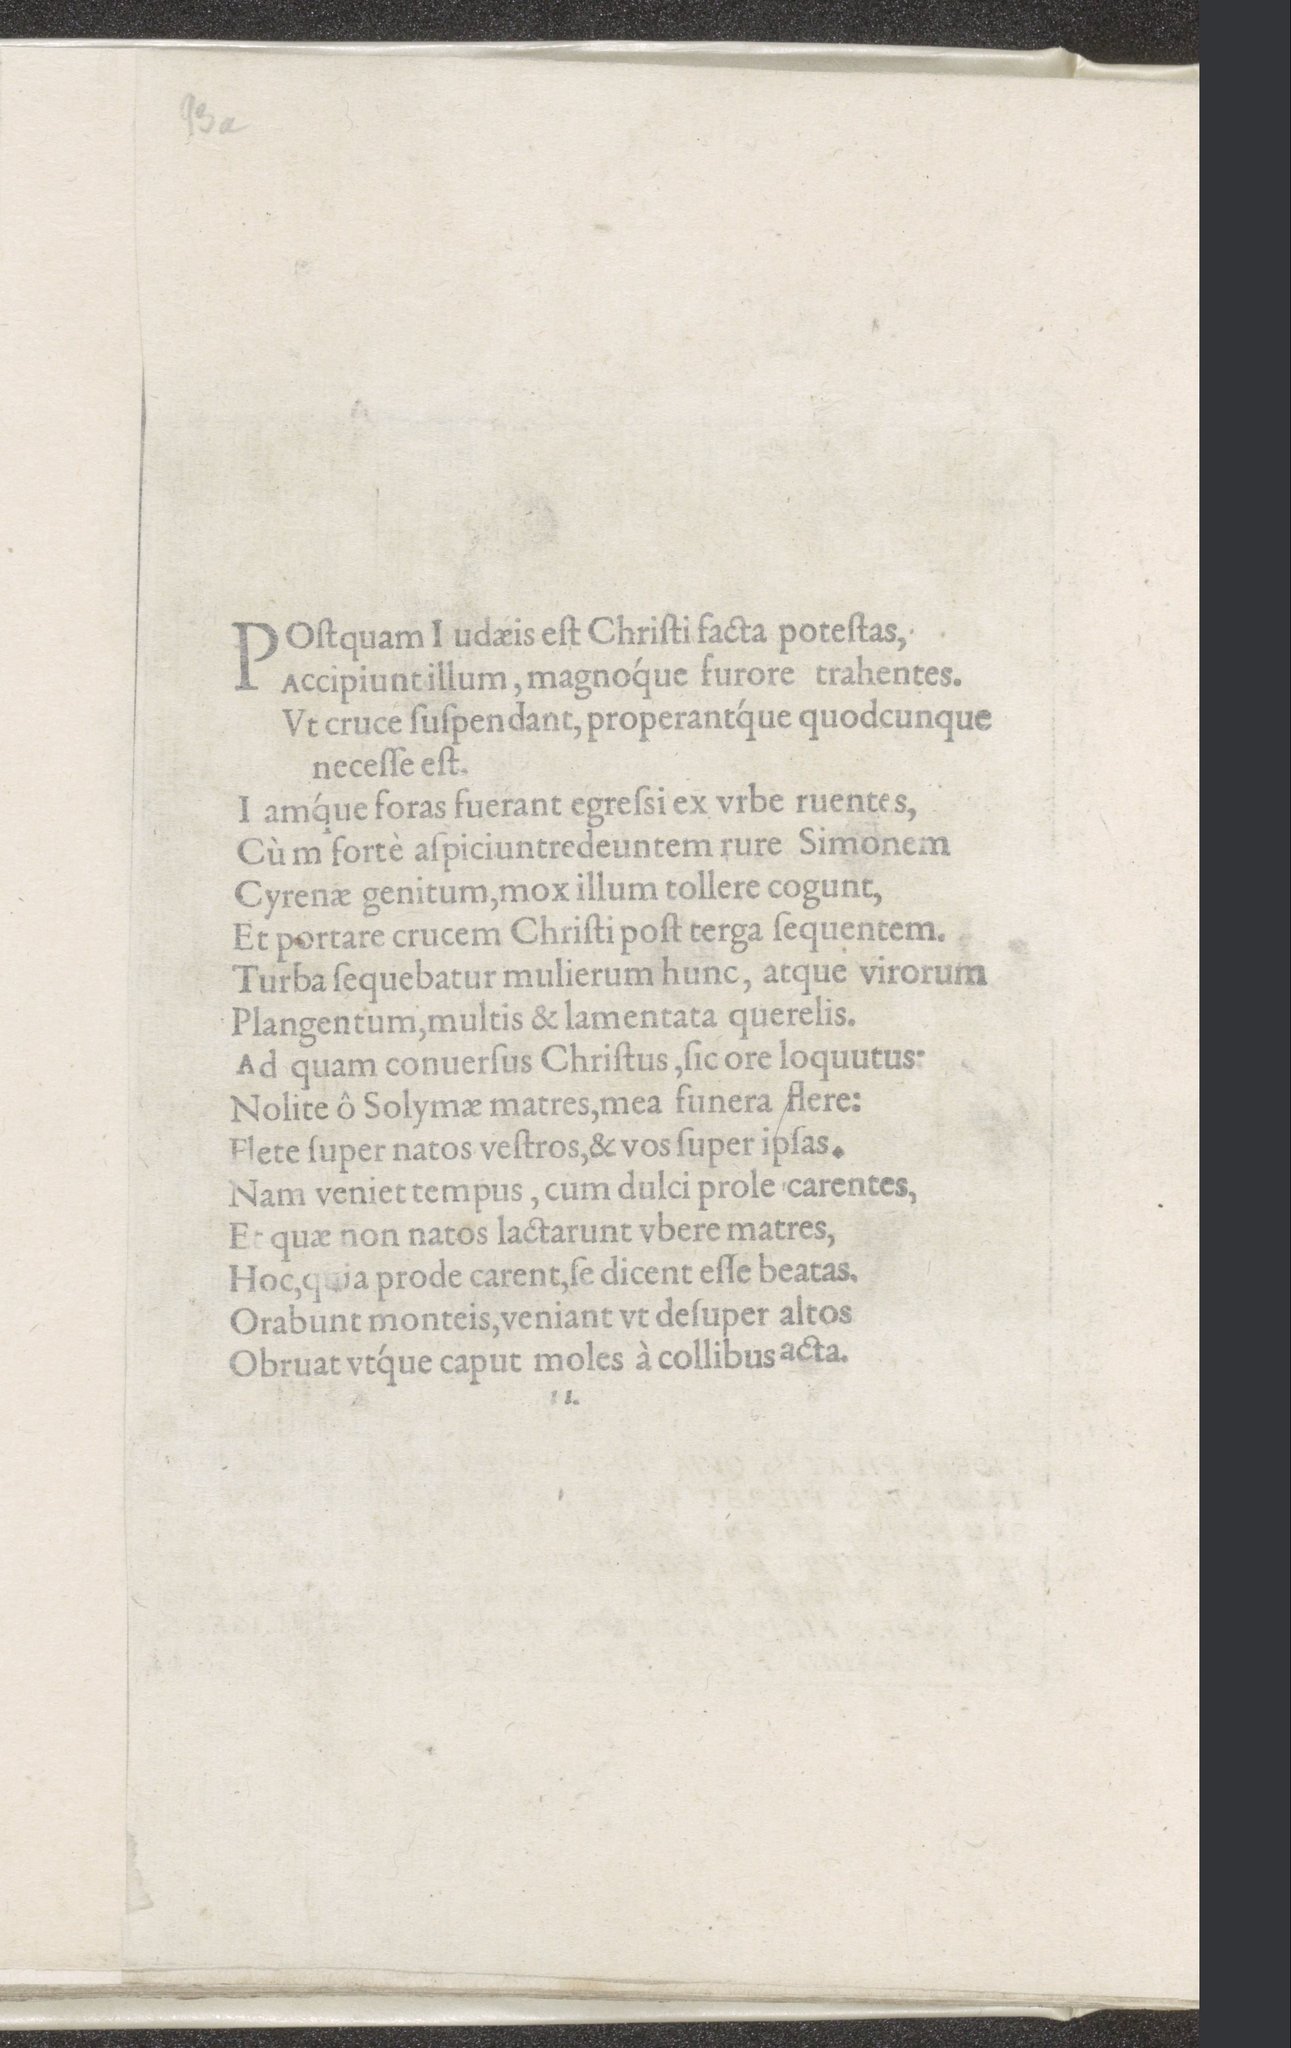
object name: album leaf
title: Passie van Christus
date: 1572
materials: paper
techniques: letterpress printing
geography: antwerp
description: Tijdens de restauratie in 1988 bleek dat op de achterzijde van de prenten van de Passie-serie van Wierix Latijnse teksten in boekdruk staan. Deze vormen, wanneer op de juiste wijze in boekvorm gebonden (wat nu in het Heemskerck-album niet het geval is), een toelichting op de passievoorstellingen. Om de teksten zichtbaar te laten zijn de prenten bij de restauratie niet meer met de achterzijde op elkaar geplakt.